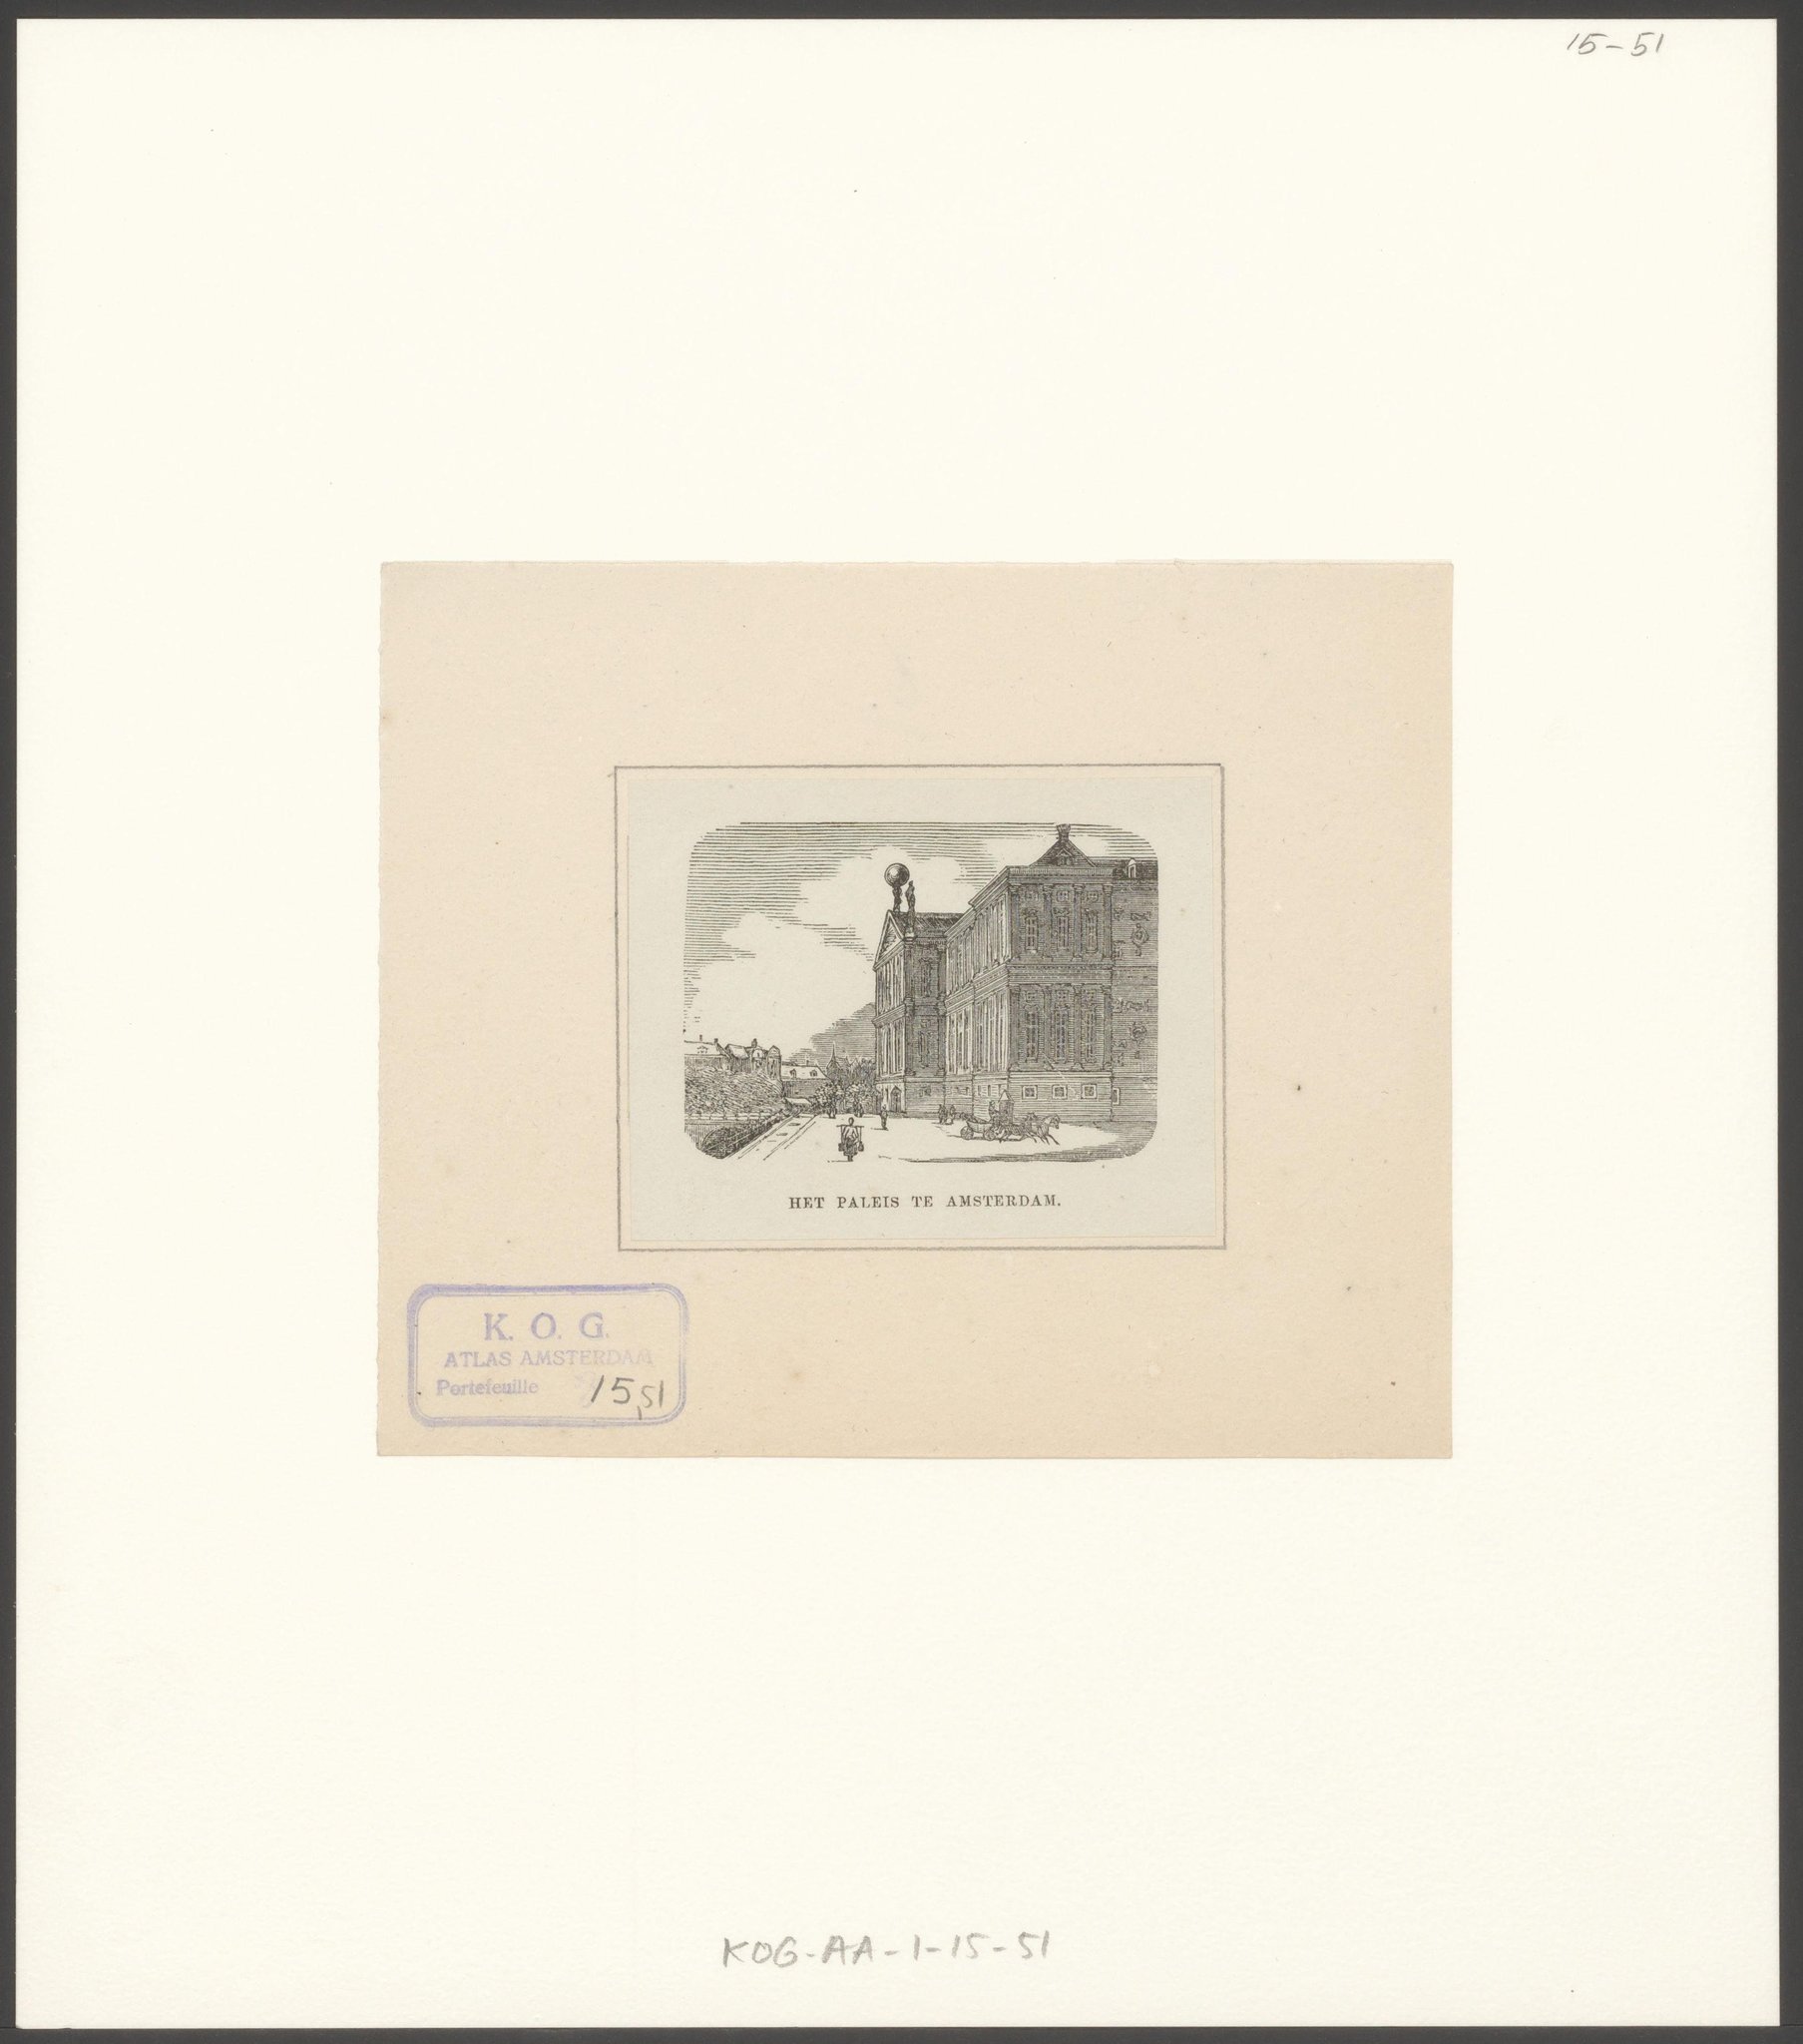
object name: photomechanical print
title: Gezicht op het Paleis op de Dam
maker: Anonymous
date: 1800-1899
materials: paper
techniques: letterpress printing, line block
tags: city-view in general; 'veduta', townhall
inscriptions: collector's mark: ‘15,51’ Lugt 1641b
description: Onderwerpsrubriek binnen de Atlas Amsterdam: Nieuwe Stadhuis, als Paleis, op de Dam, van Buiten.